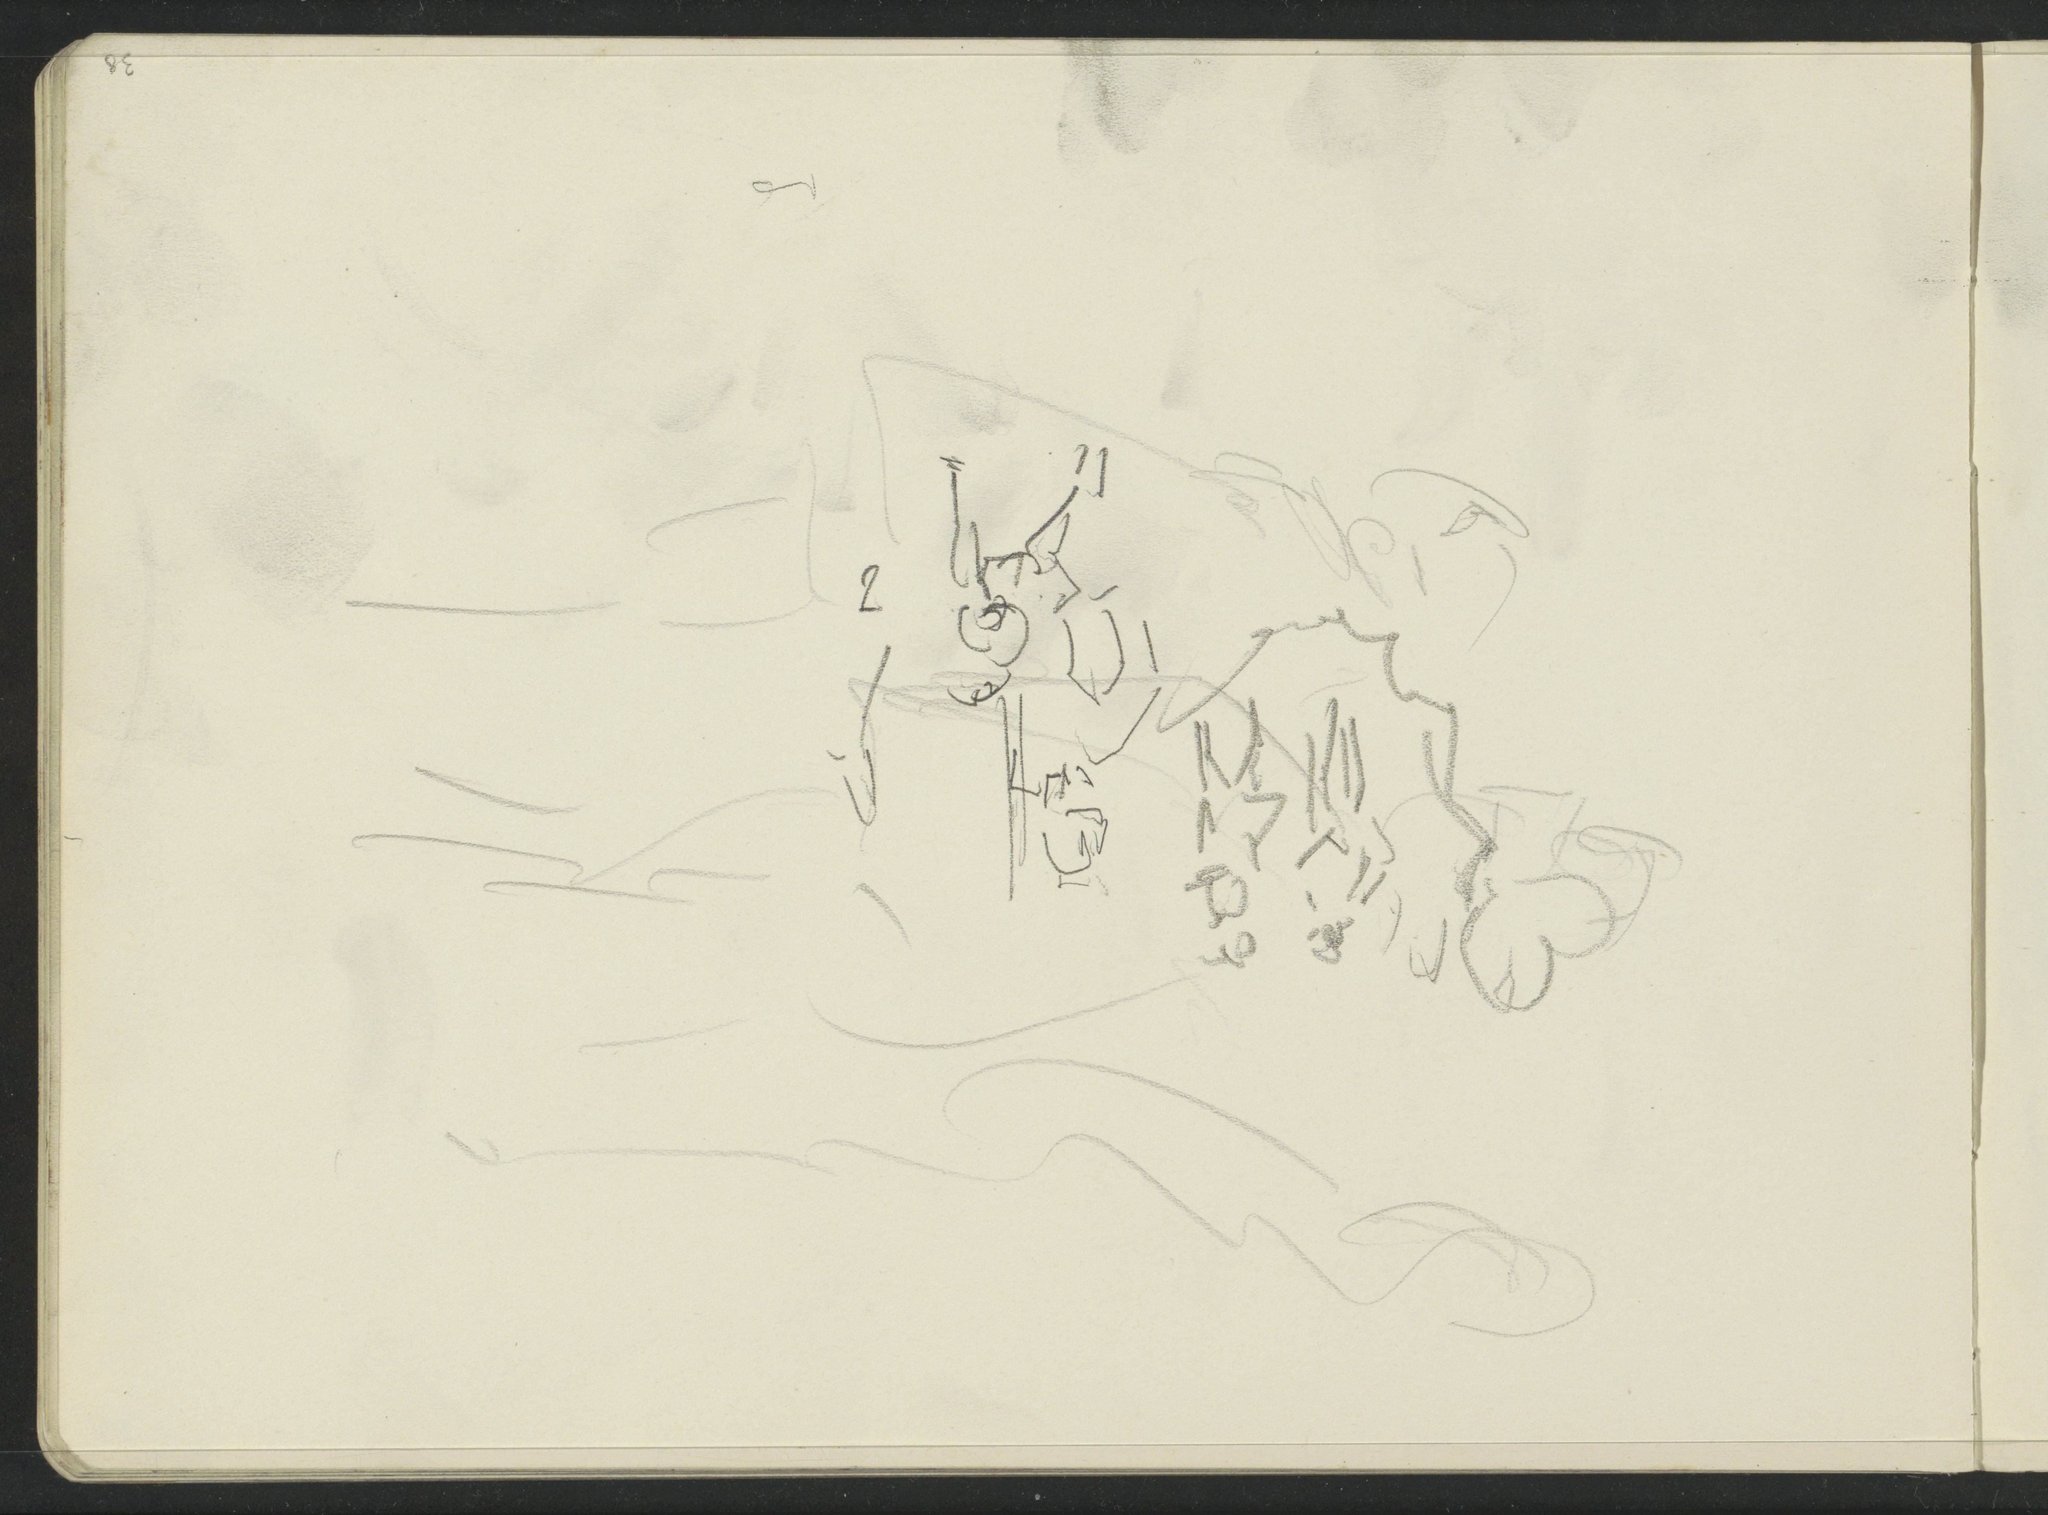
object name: sketchbook leaf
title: Figuurstudies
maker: isaac israels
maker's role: draughtsman, painter, print maker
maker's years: 1865-1934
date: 1915-1934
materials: paper, pencil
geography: the hague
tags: adult woman, postures of the human figure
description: Mogelijk vrouwen. Blad 33 verso uit schetsboek XVIII met 35 bladen.